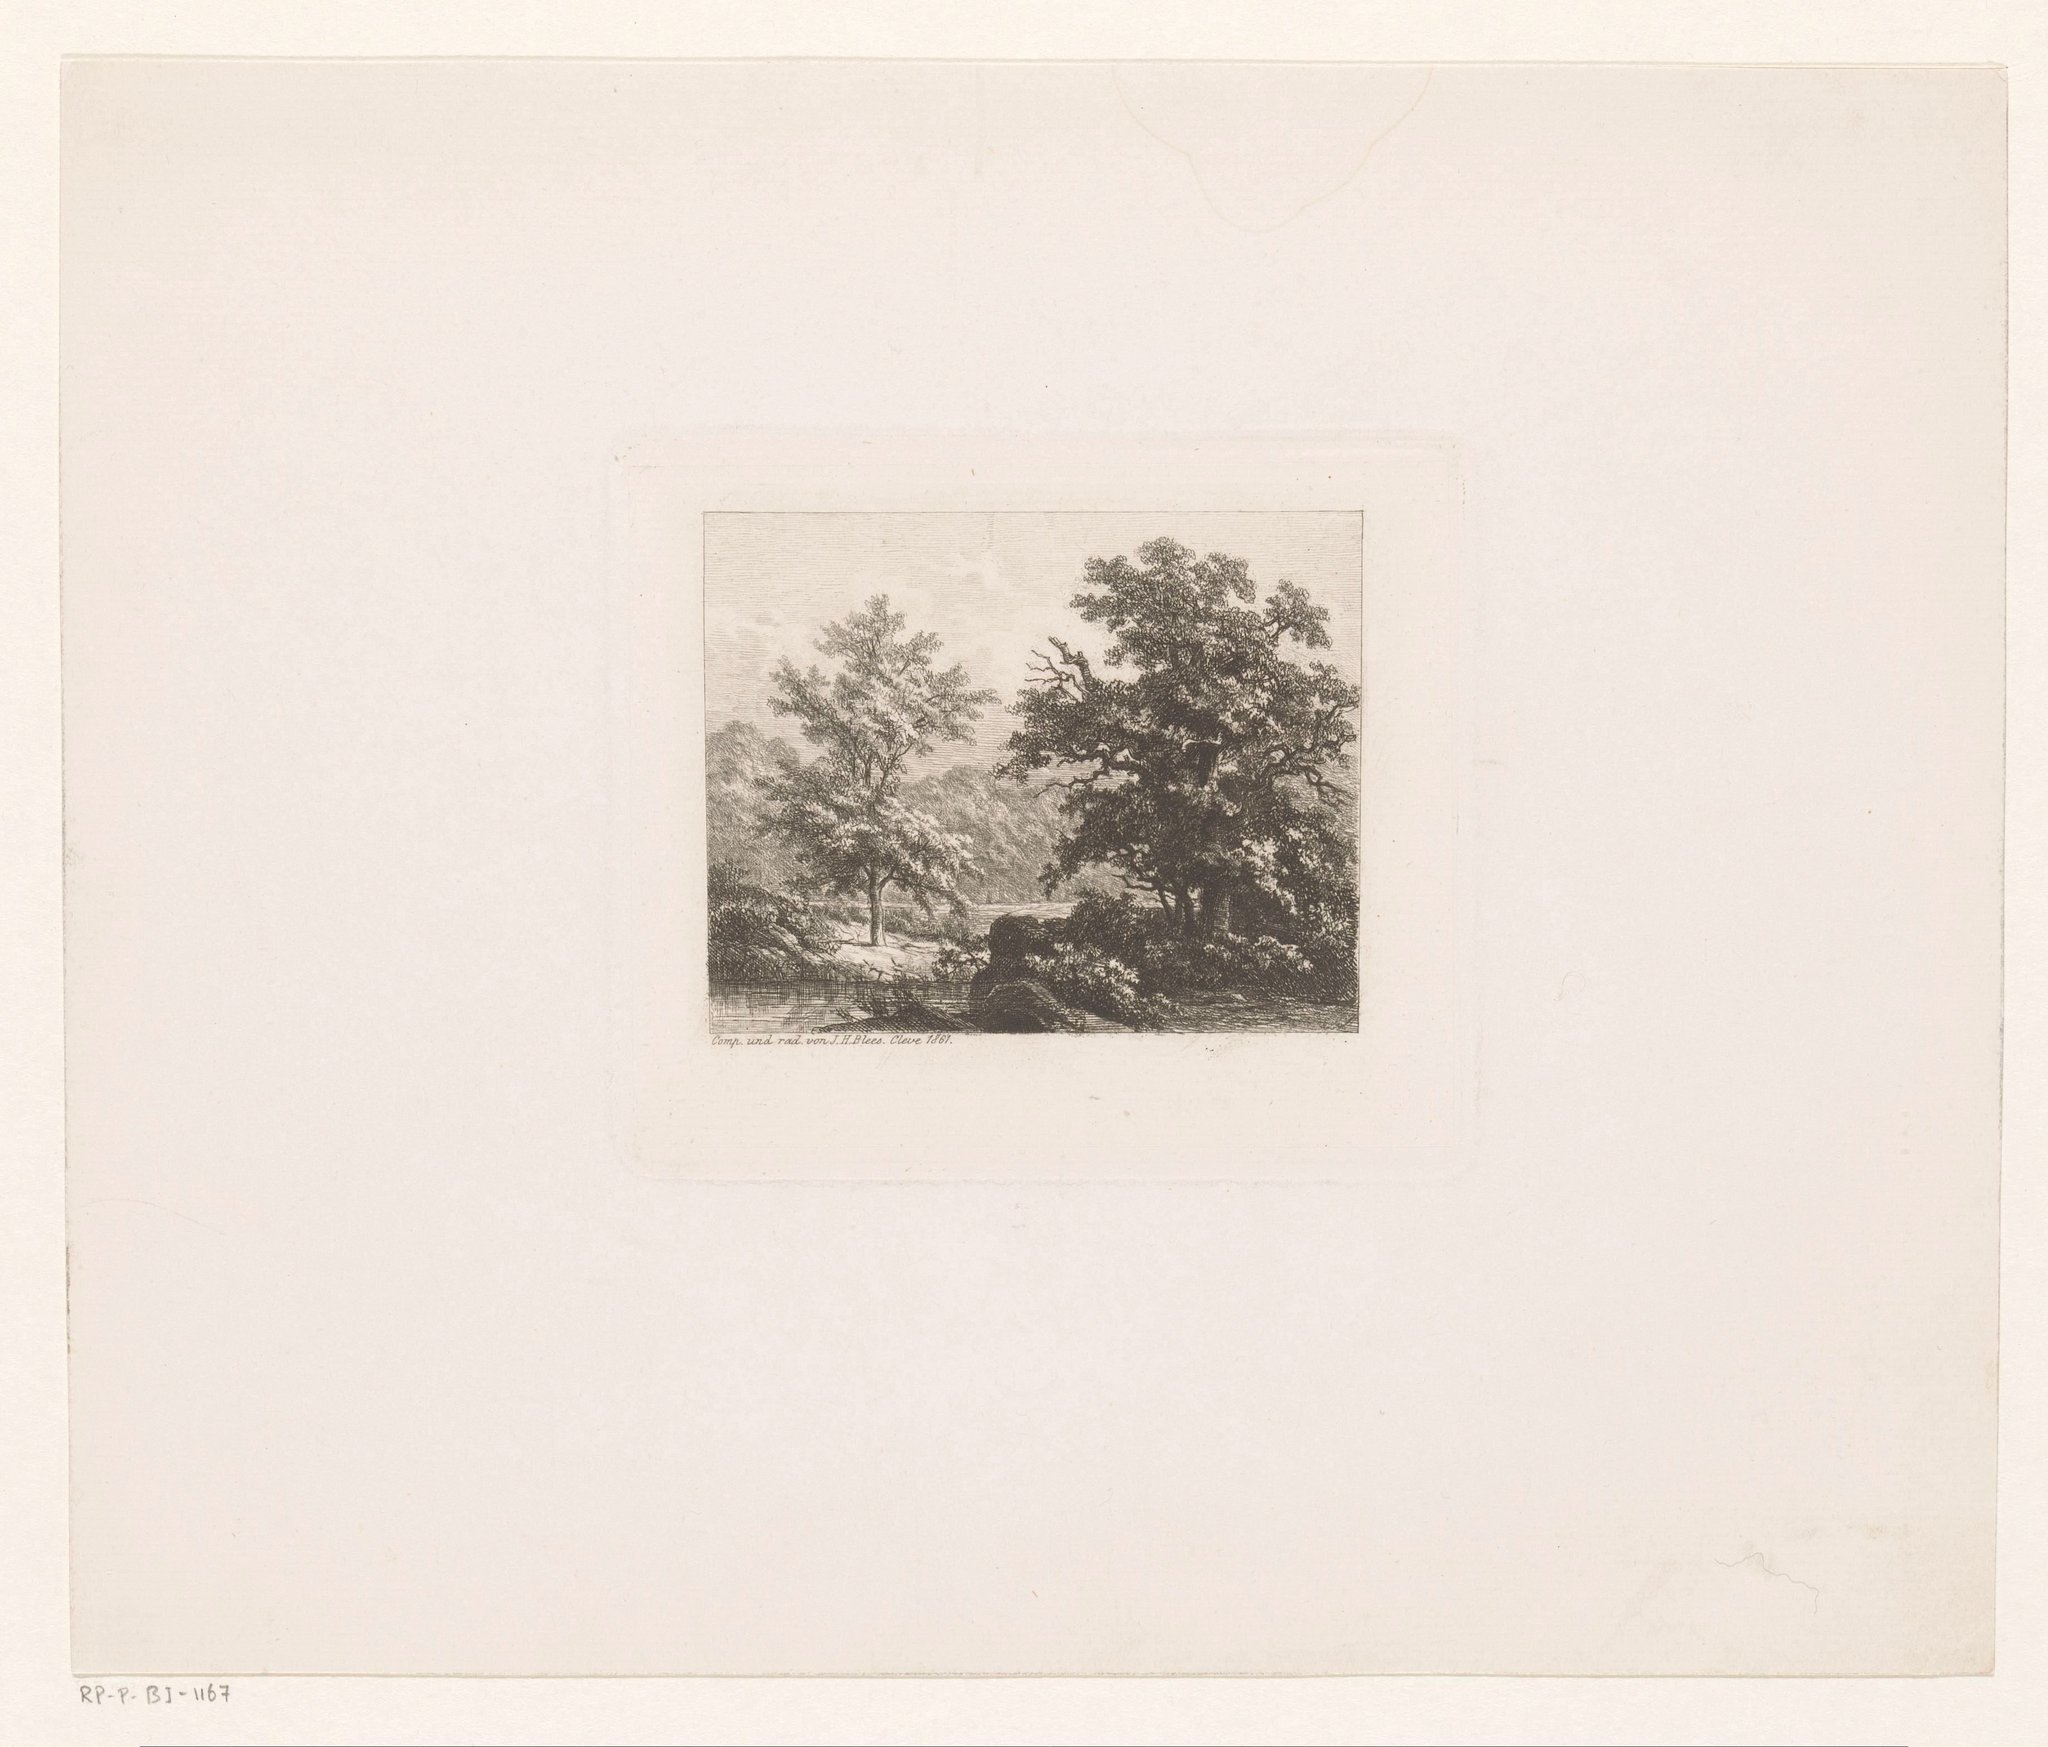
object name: print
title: Bosgezicht met links een waterpartij voor een alleenstaande boom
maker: joseph hubert blees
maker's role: print maker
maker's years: 1826-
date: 1861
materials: paper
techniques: etching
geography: cleves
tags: forest, wood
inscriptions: collector's mark: Lugt 2228